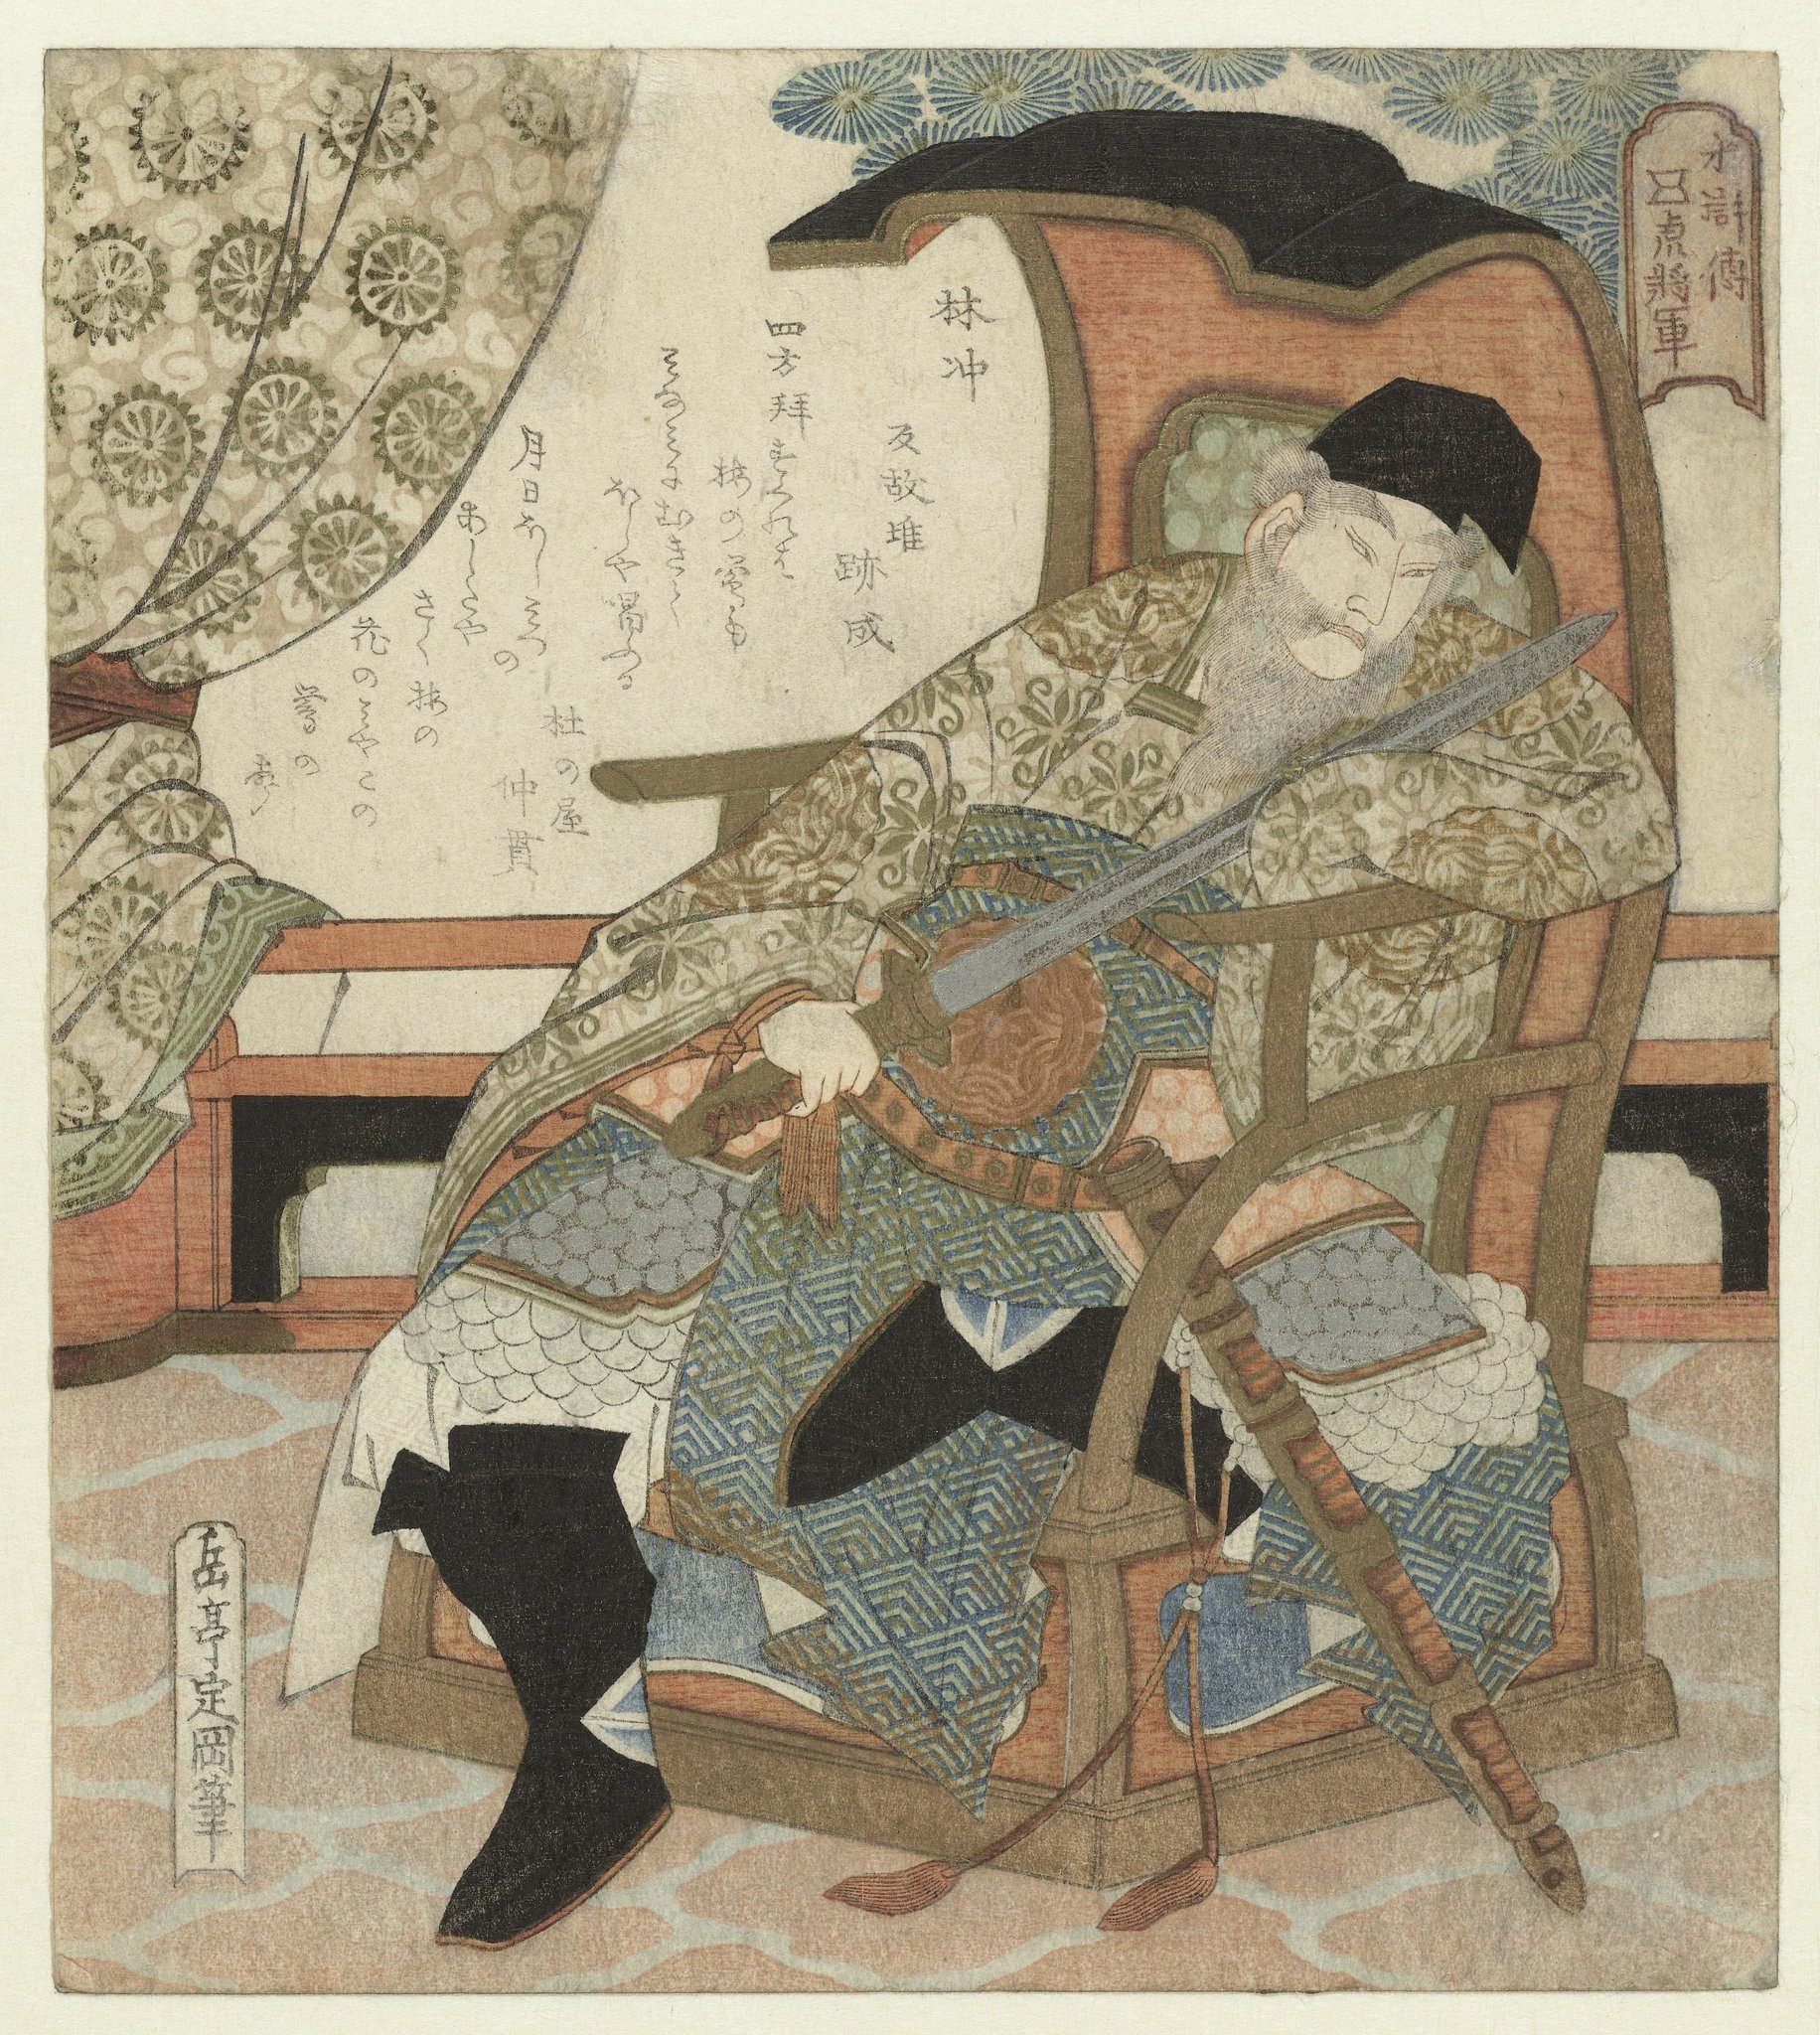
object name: surimono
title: De Chinese generaal Lin Ch'ung (Tenyûsei Hyôshitô Rinchû)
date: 1827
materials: paper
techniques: blind stamped, woodcut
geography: japan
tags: hacking and thrusting weapons: sword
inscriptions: collector's mark, verso, stamped: Lugt 2228, collector's mark, passe-partout, bottom left, printed: JABdH with a rooster.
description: Een surimono is een luxe uitgevoerde prent waarop beeld met één of meerdere gedichten gecombineerd is. Bij het drukken van een surimono werd vaak gebruik gemaakt van dikker papier, blinddruk en metaal pigmenten, zoals koper- en zilverpoeder. De prenten werden vaak in opdracht van dichters gemaakt en als exclusief geschenk aan vrienden en relaties gegeven.